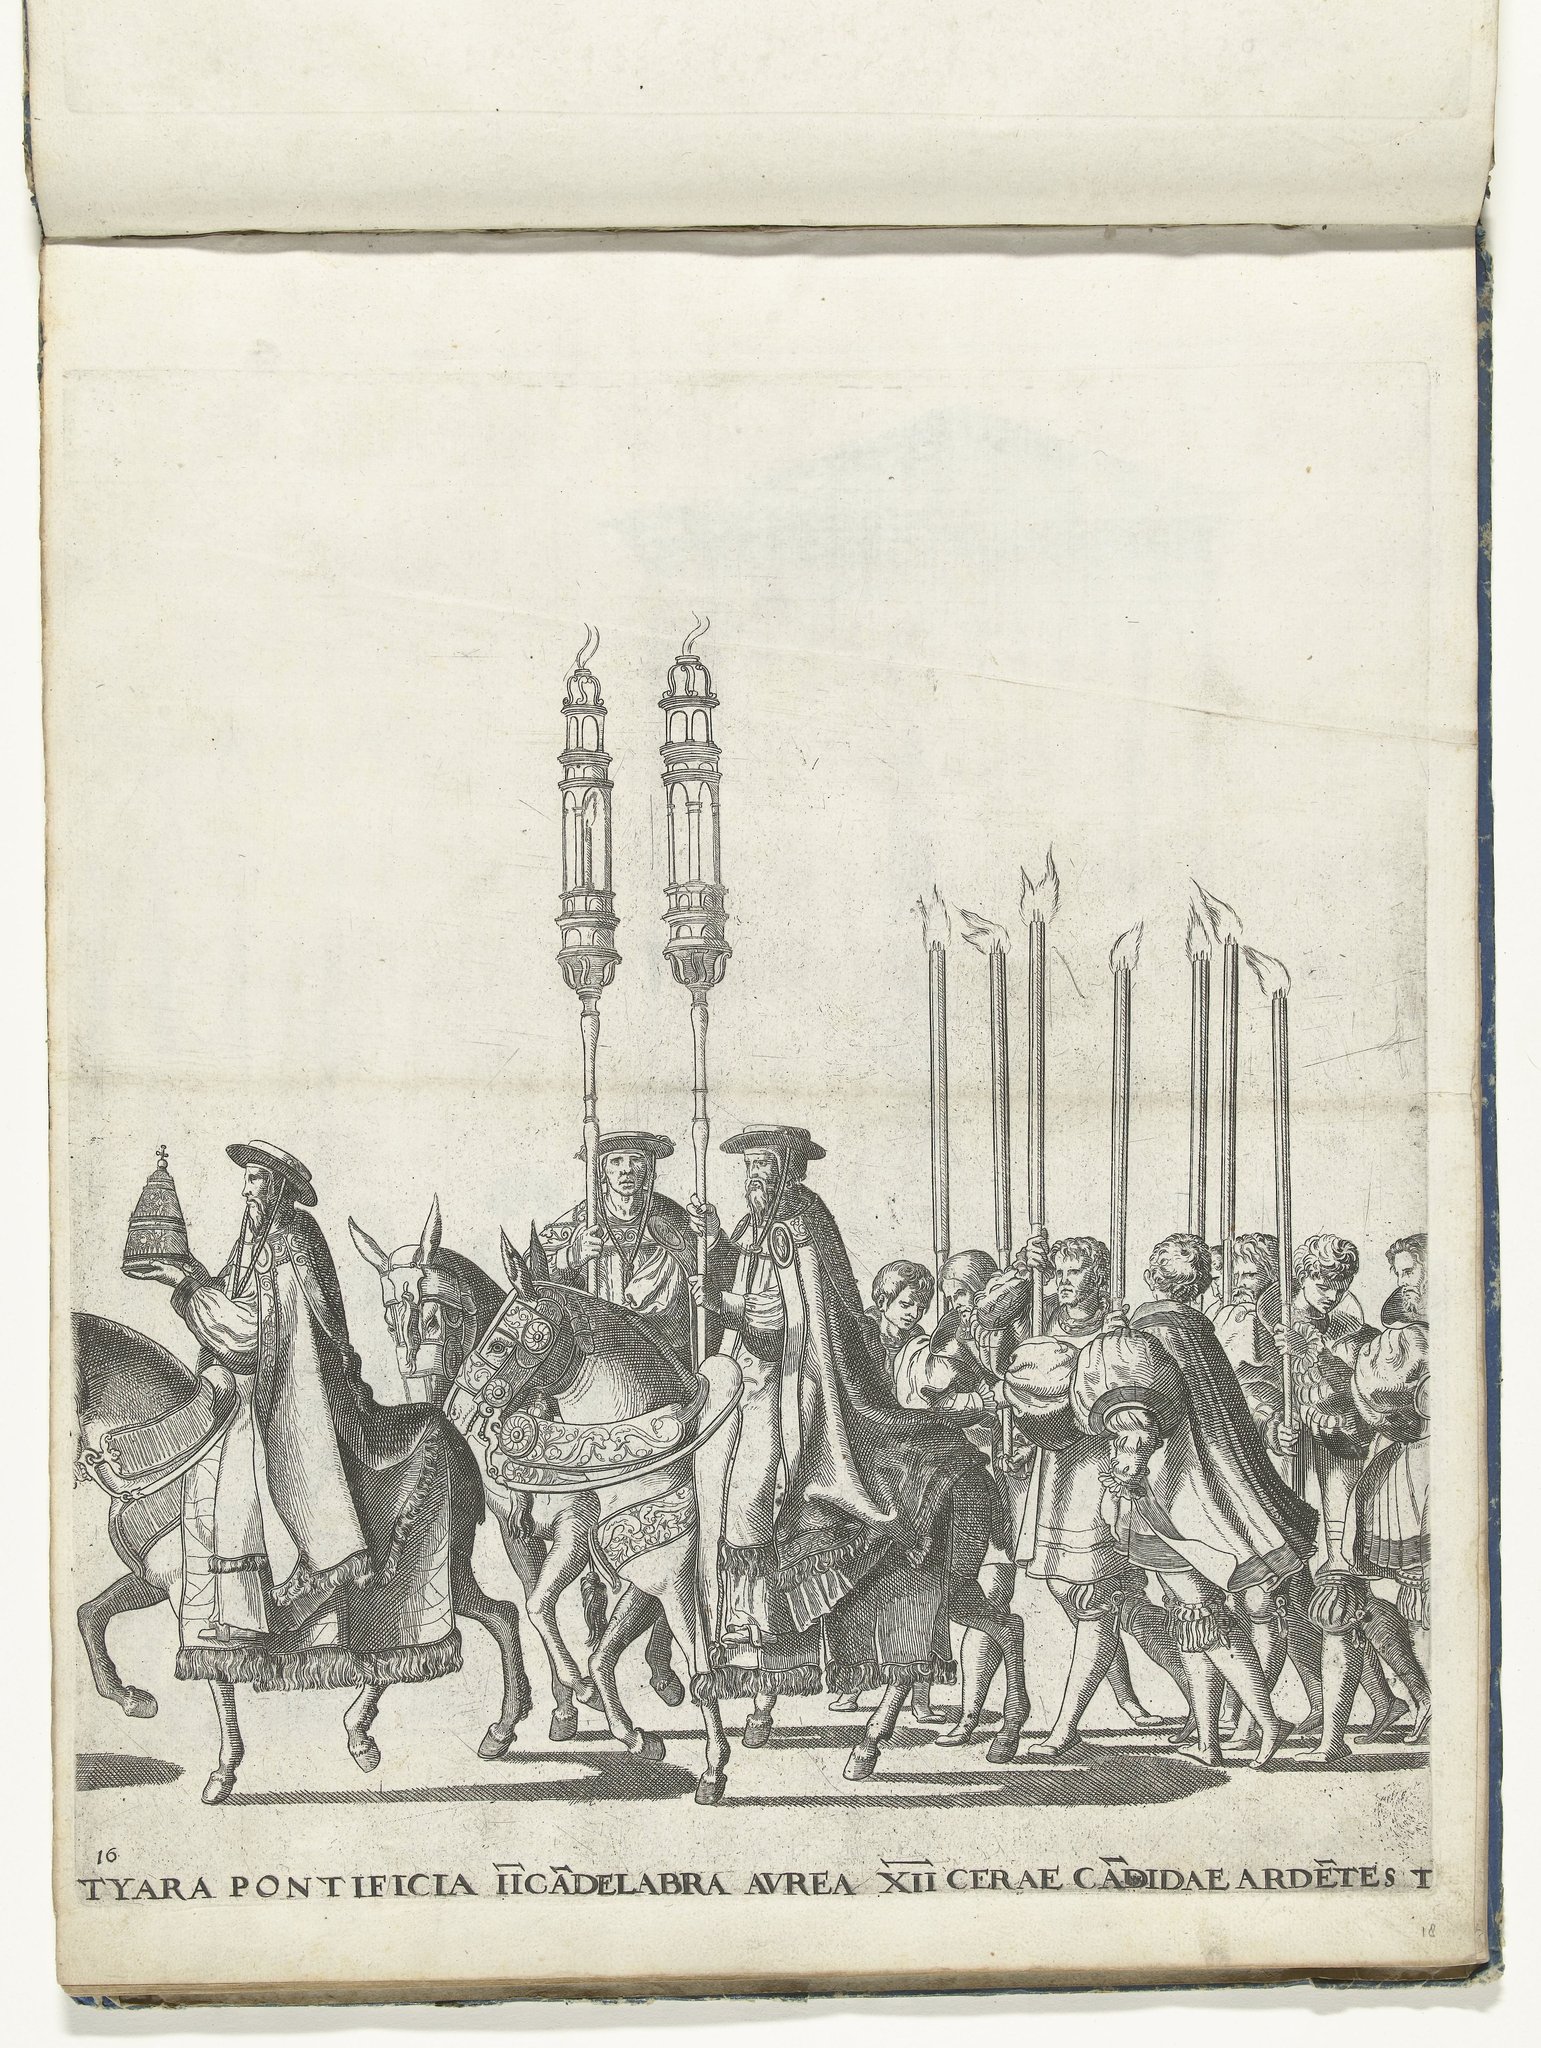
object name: print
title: Pauselijke tiara en kandelaren, plaat 16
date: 1530-1536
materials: paper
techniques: engraving, etching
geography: the hague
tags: charles v (holy roman emperor and king of spain), rome, festivities (+ parade, pageant, cavalcade ~ festive activities)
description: Prent in het album waarin zijn ingeplakt de 40 platen die achterelkaar samen het fries vormen van de optocht van Karel V met de paus Clemens VII te Bologna na zijn kroning tot keizer, 24 februari 1530.